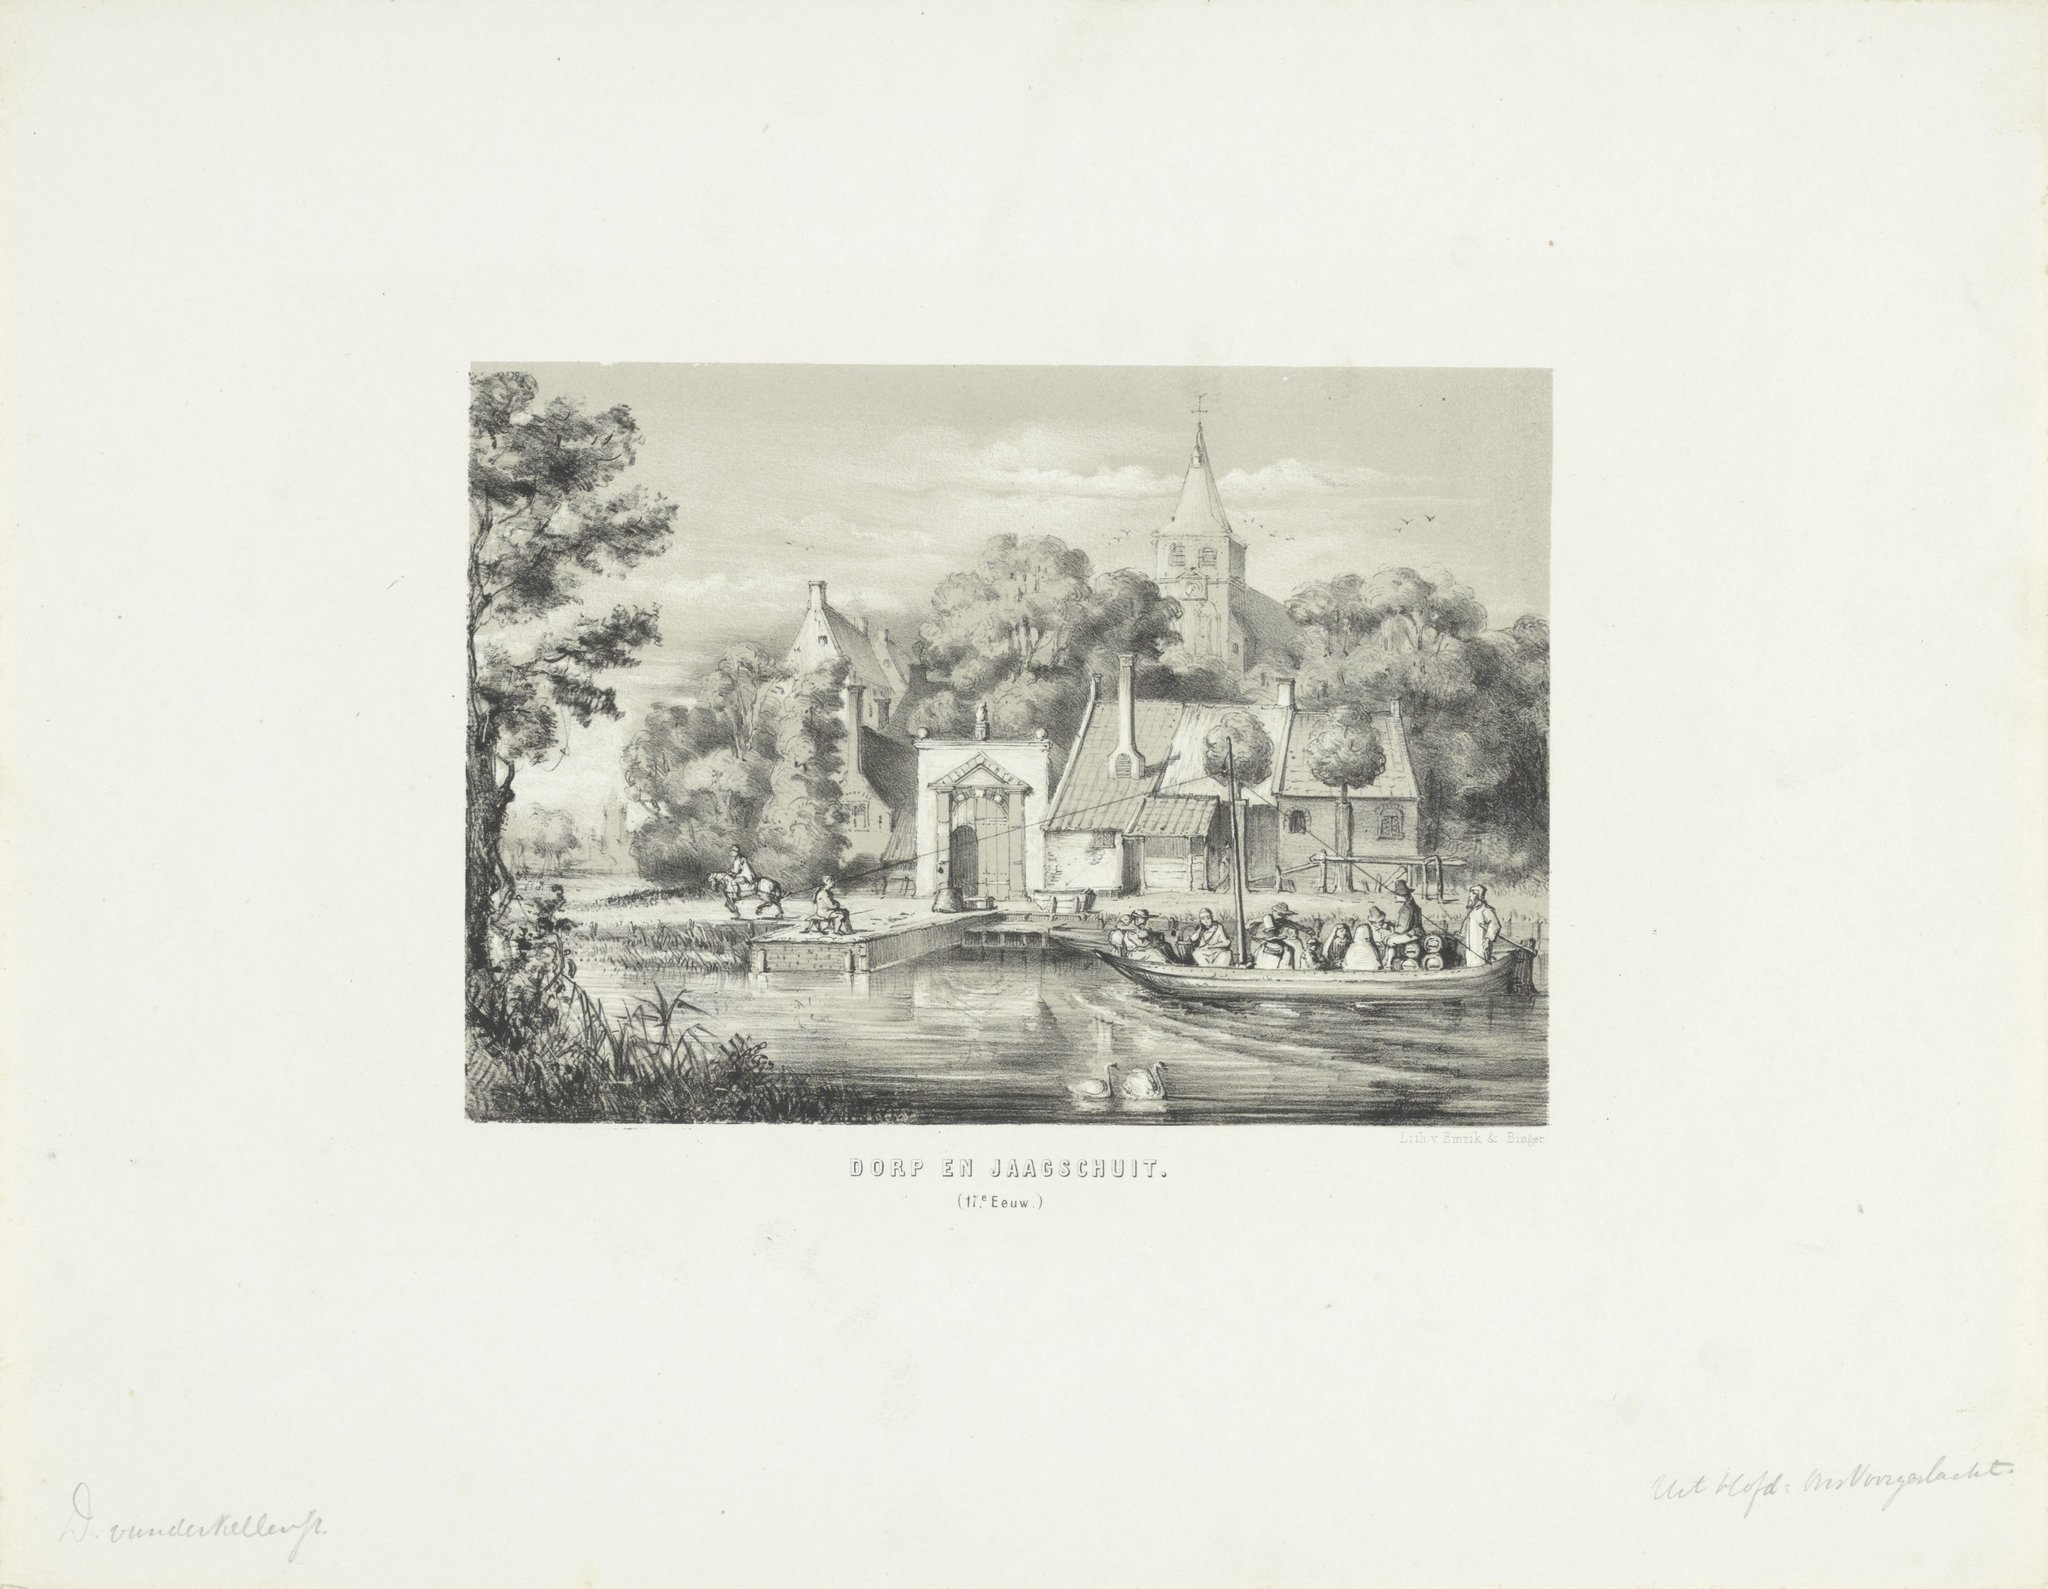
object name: book illustration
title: Dorp en jaagschuit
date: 1857-1864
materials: paper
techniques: tone lithography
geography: haarlem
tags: village, pier, quay, wharf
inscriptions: collector's mark: Lugt 2228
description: Rechts komt een schuit aangevaren, vol met figuren. De schuit wordt naar de aanlegsteiger getrokken door een ruiter te paard. Daarachter een dorp met een toegangspoort, enkele huizen en een kerk.